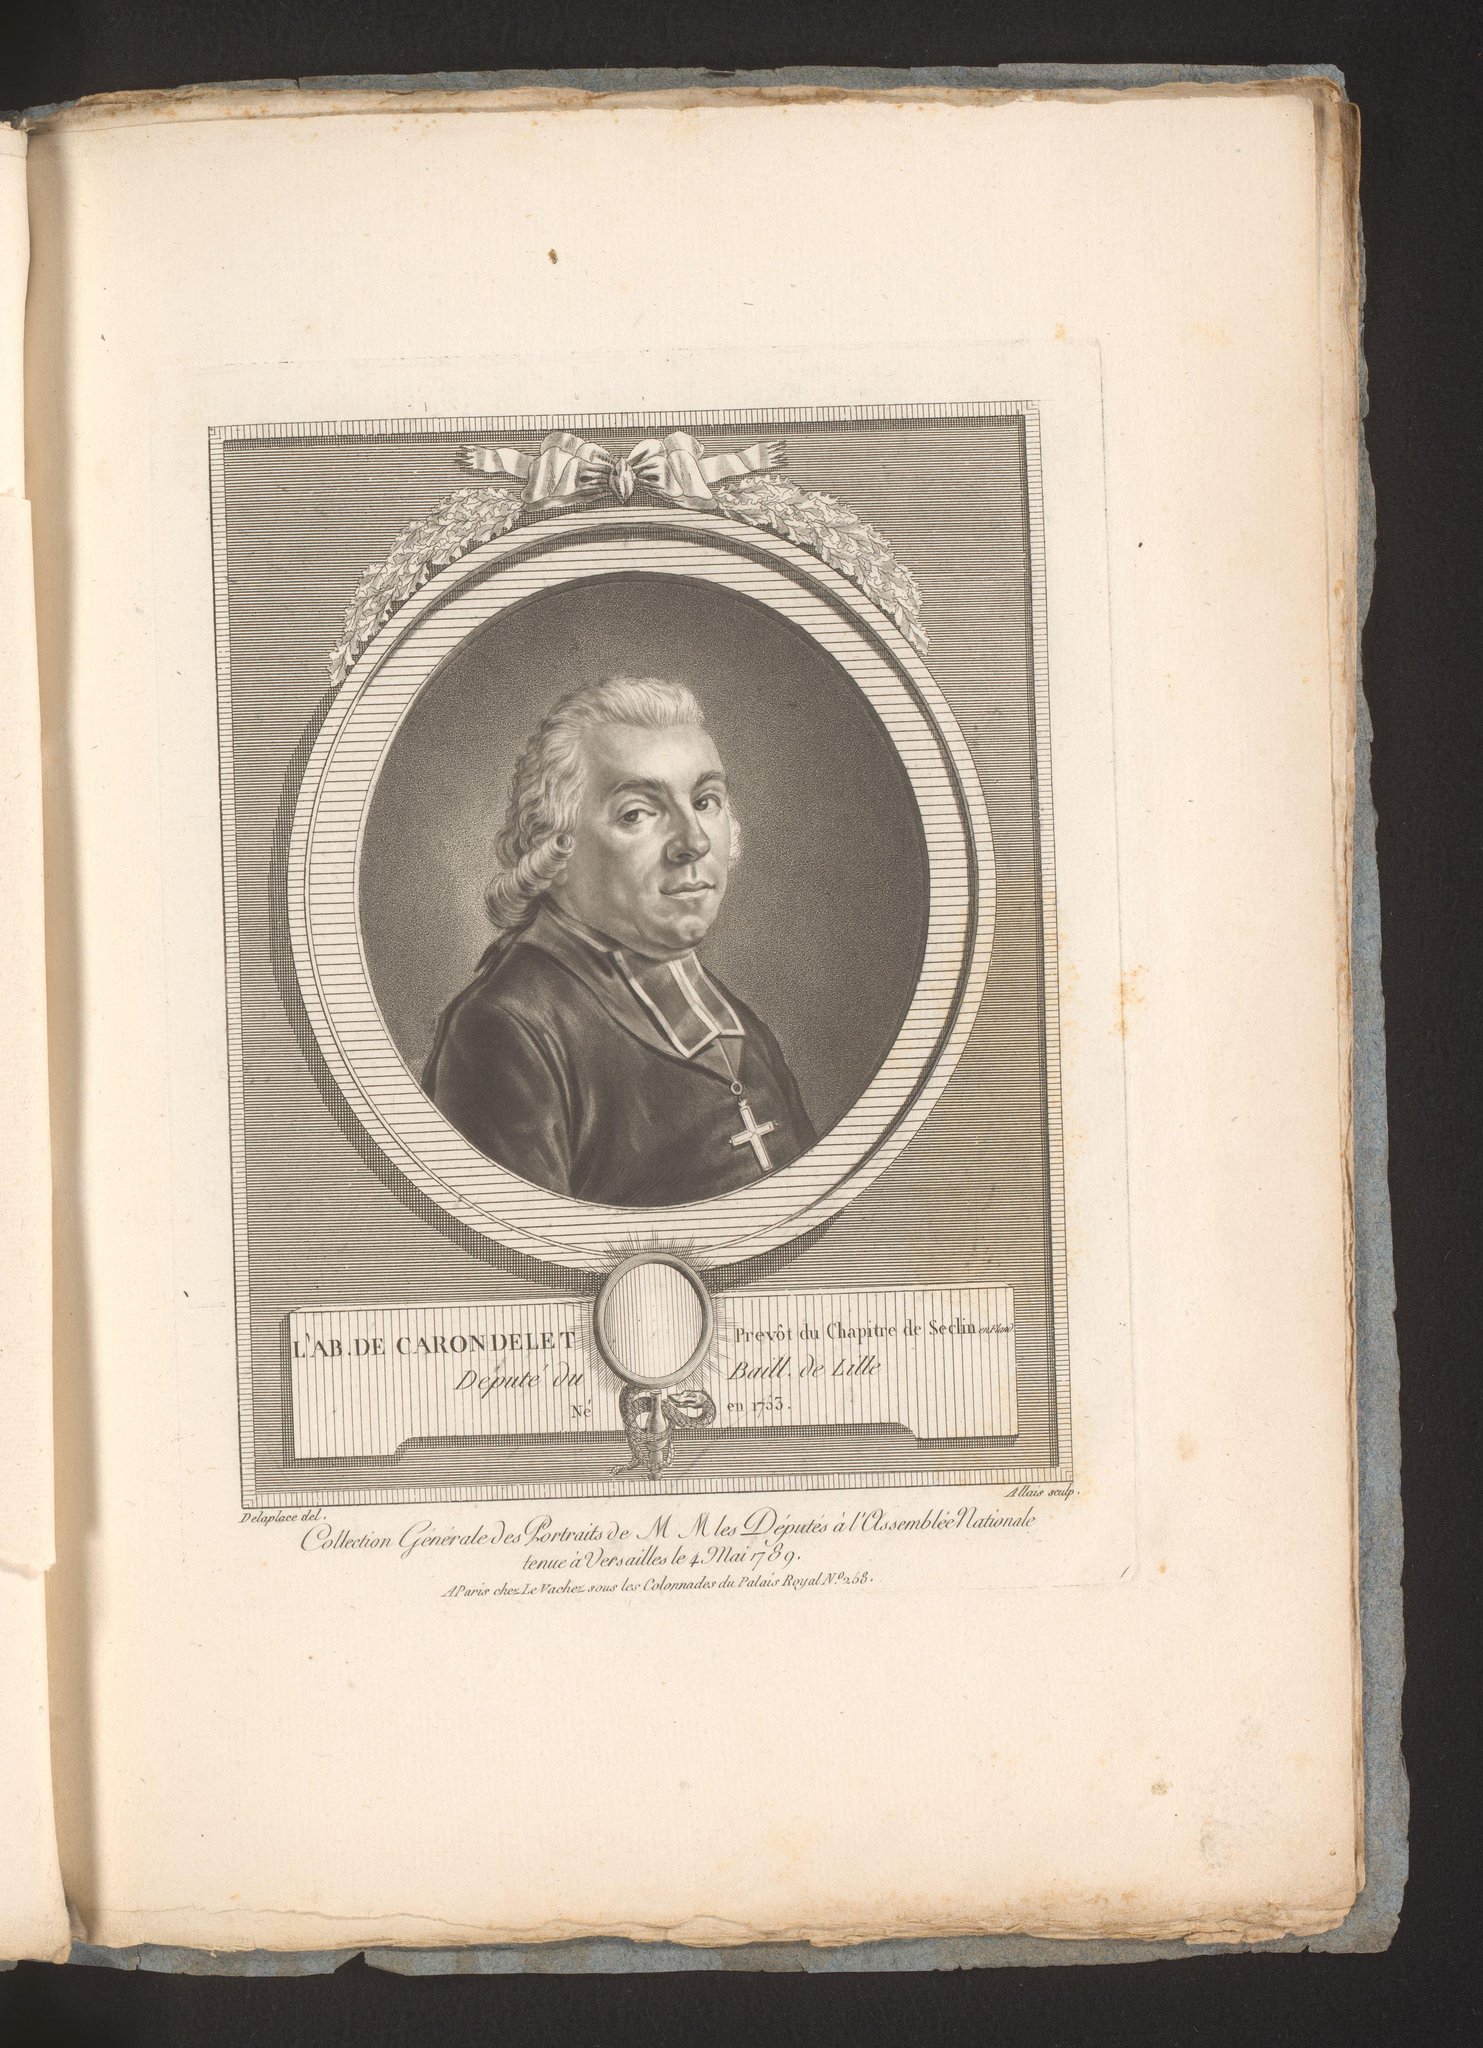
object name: print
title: Portretten van afgevaardigden aanwezig bij de vergadering van de Staten-Generaal op 4 mei 1789 te Versailles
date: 1790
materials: paper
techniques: aquatint, etching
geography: paris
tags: historical persons, politics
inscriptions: collector's mark: Lugt 2760, collector's mark: Lugt 2228